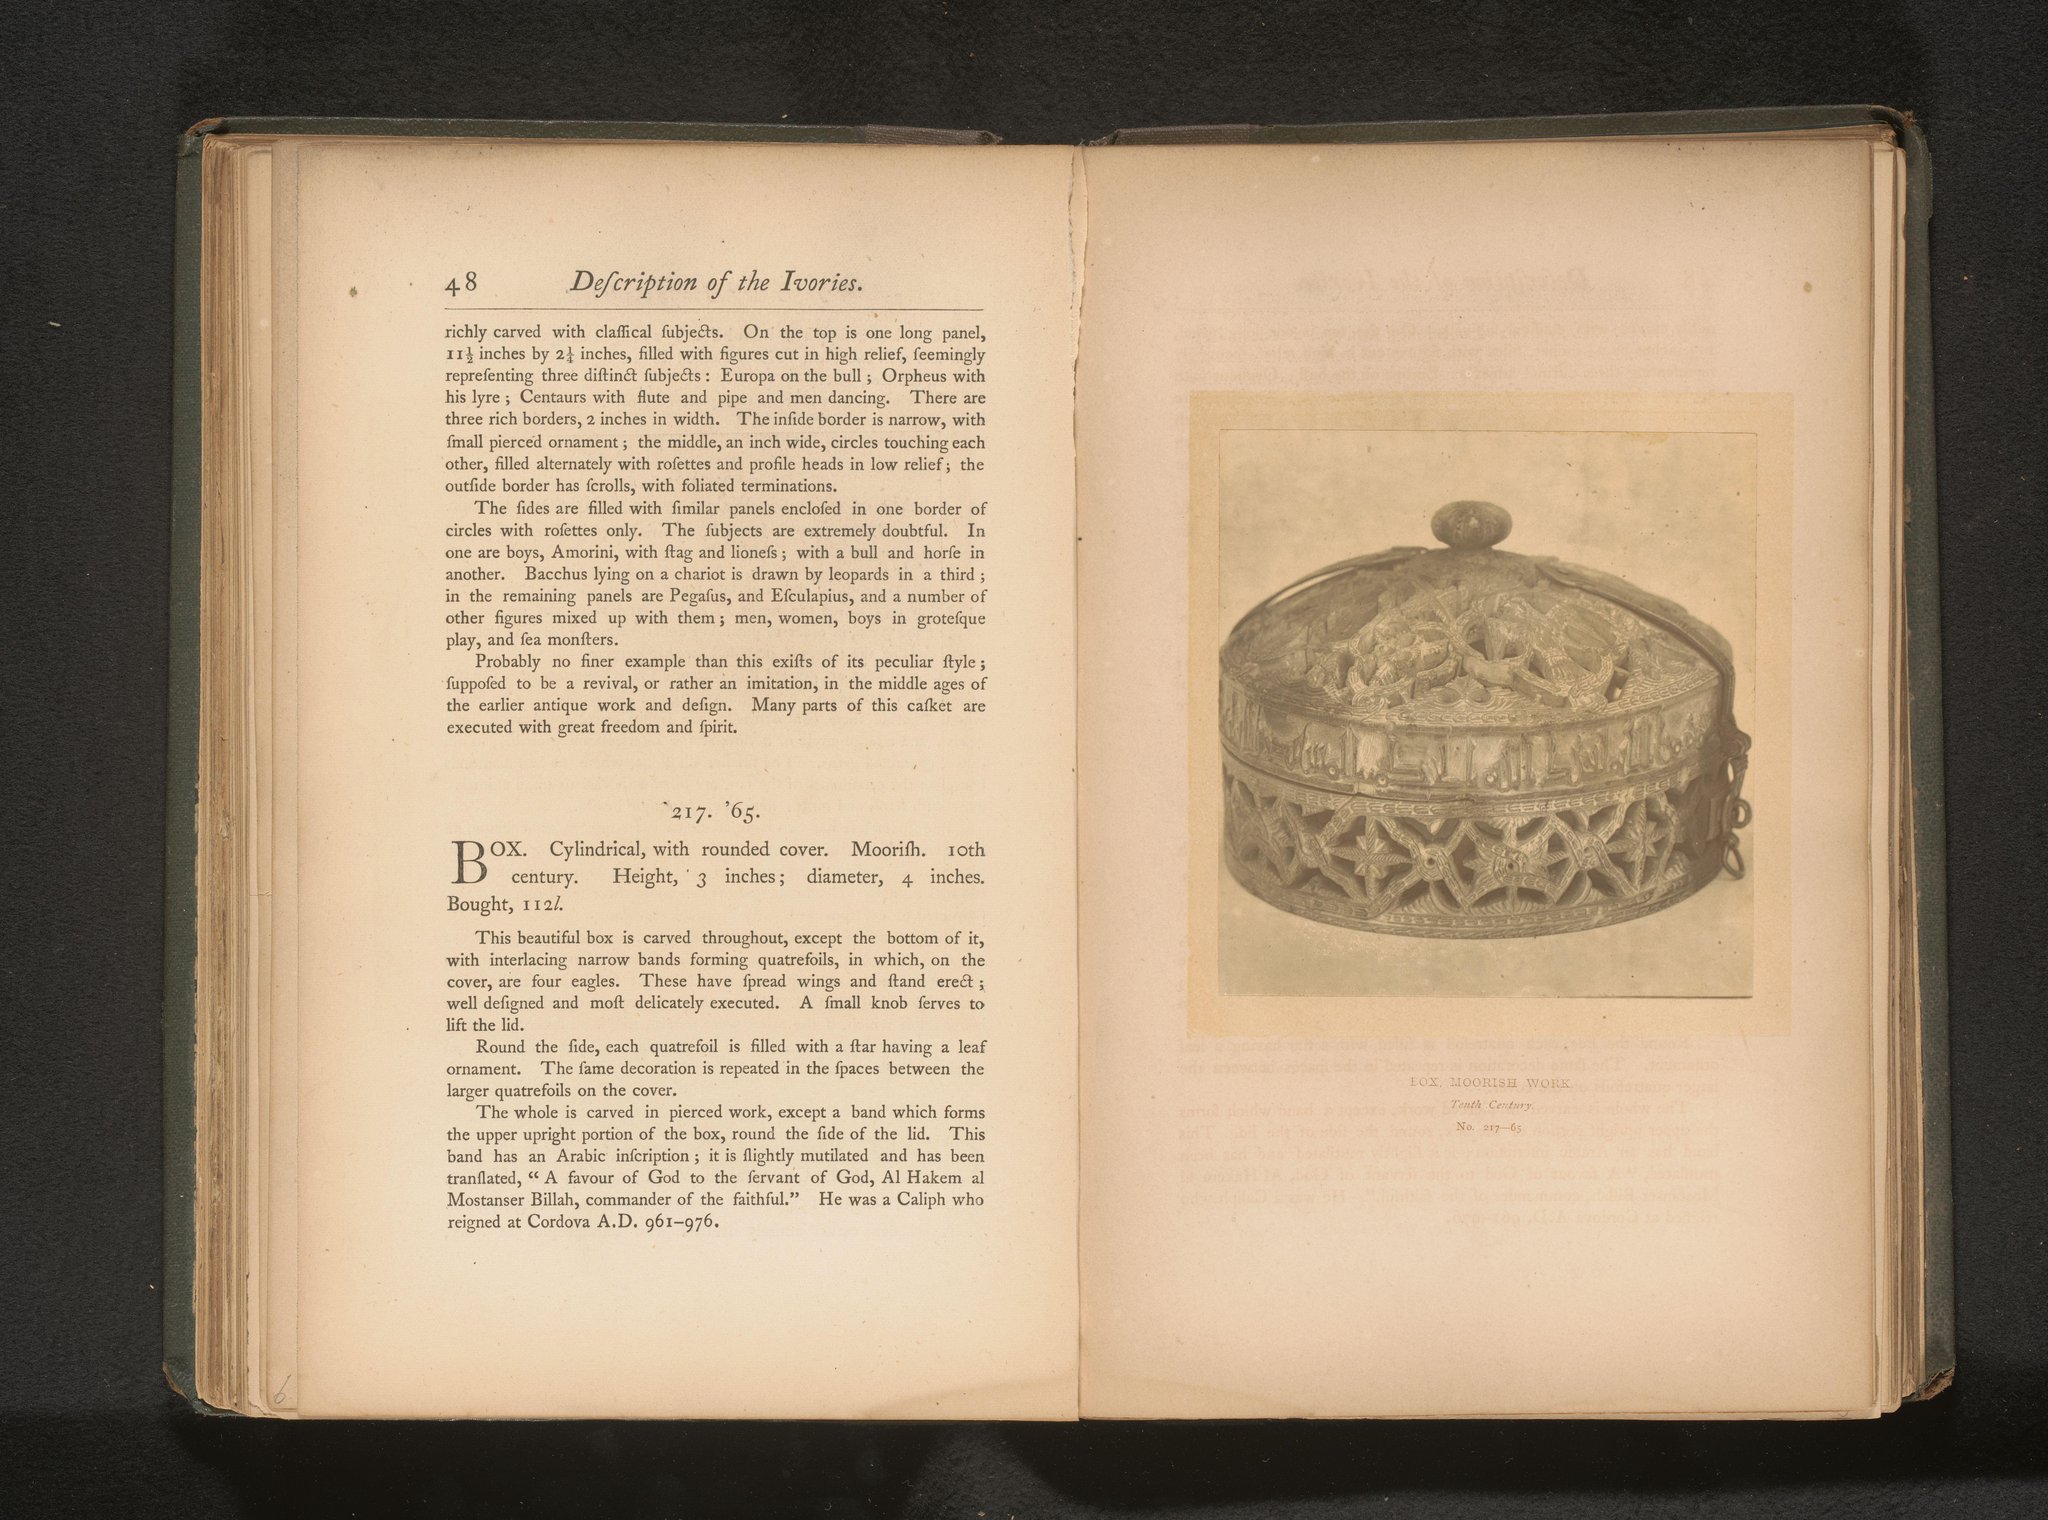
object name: page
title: Box, Moorish work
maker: Anonymous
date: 1867-1872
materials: paper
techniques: woodburytype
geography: london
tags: containers, sculpture (+ relief ~ sculpture)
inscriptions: inscription: ‘Tenth Century.’, number: ‘No. 217-65.’